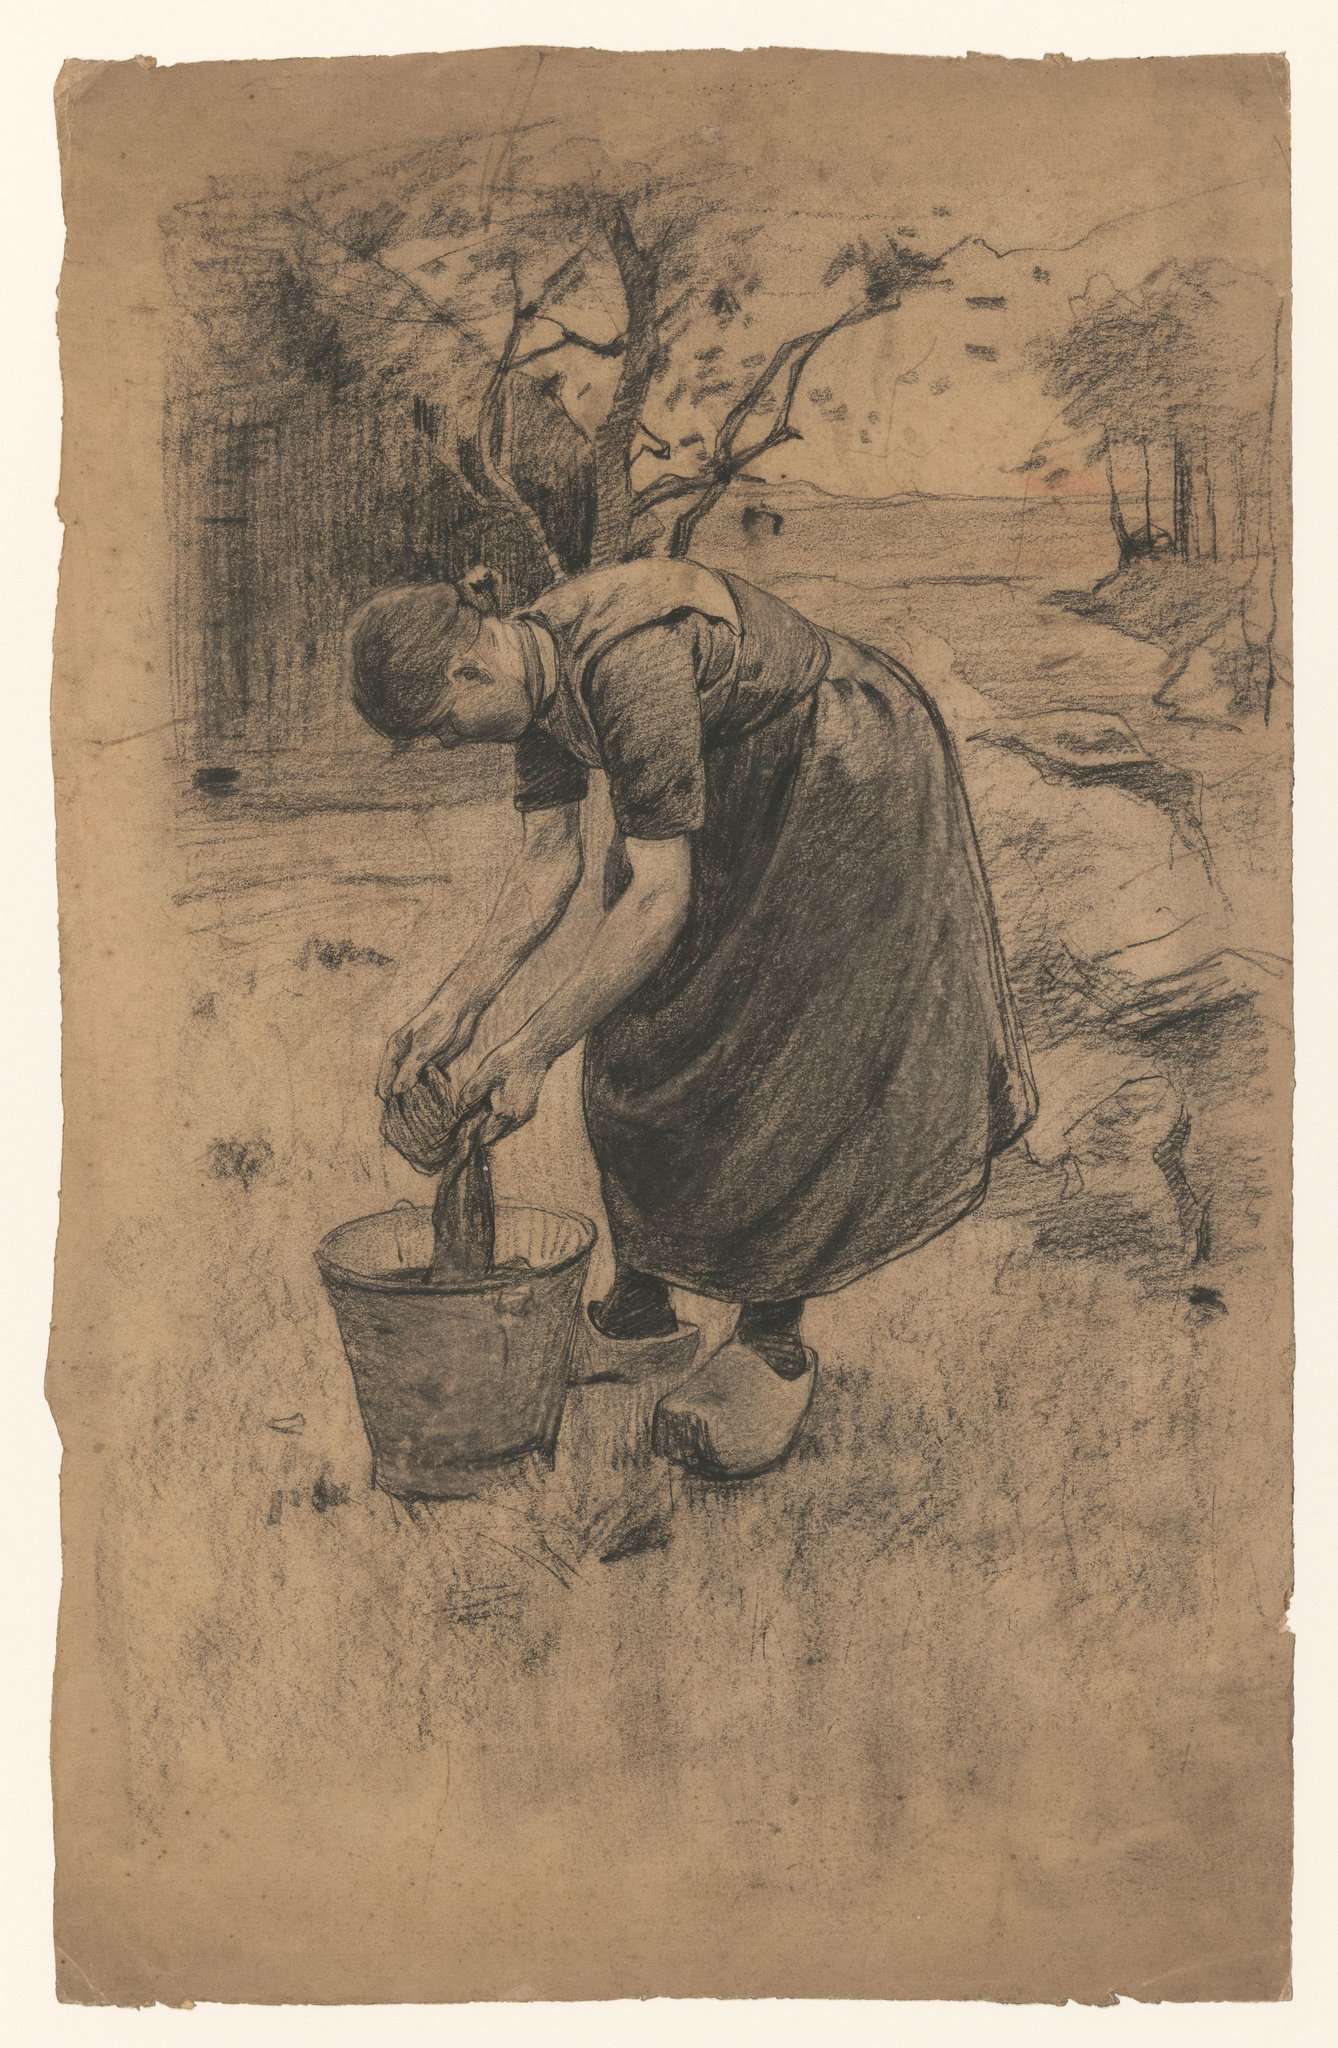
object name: drawing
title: Vrouw spoelt de was in een emmer, voor een boerderij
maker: willem witsen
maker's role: draughtsman, painter, print maker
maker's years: 1860-1923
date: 1870-1923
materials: chalk, paper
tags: female sex; woman, laundering